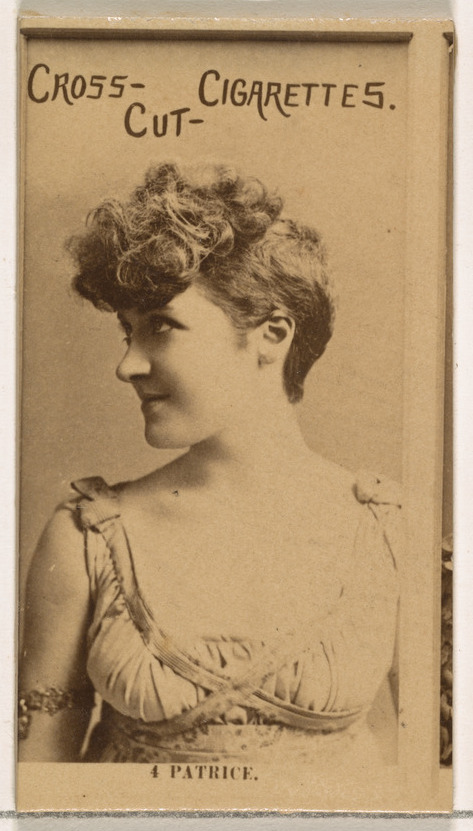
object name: print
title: Card Number 4, Patrice, from the Actors and Actresses series (N145-2) issued by Duke Sons & Co. to promote Cross Cut Cigarettes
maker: w. duke, sons & co.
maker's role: publisher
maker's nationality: american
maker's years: 1870-1920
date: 1880-1889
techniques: albumen silver print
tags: portraits,women,actresses